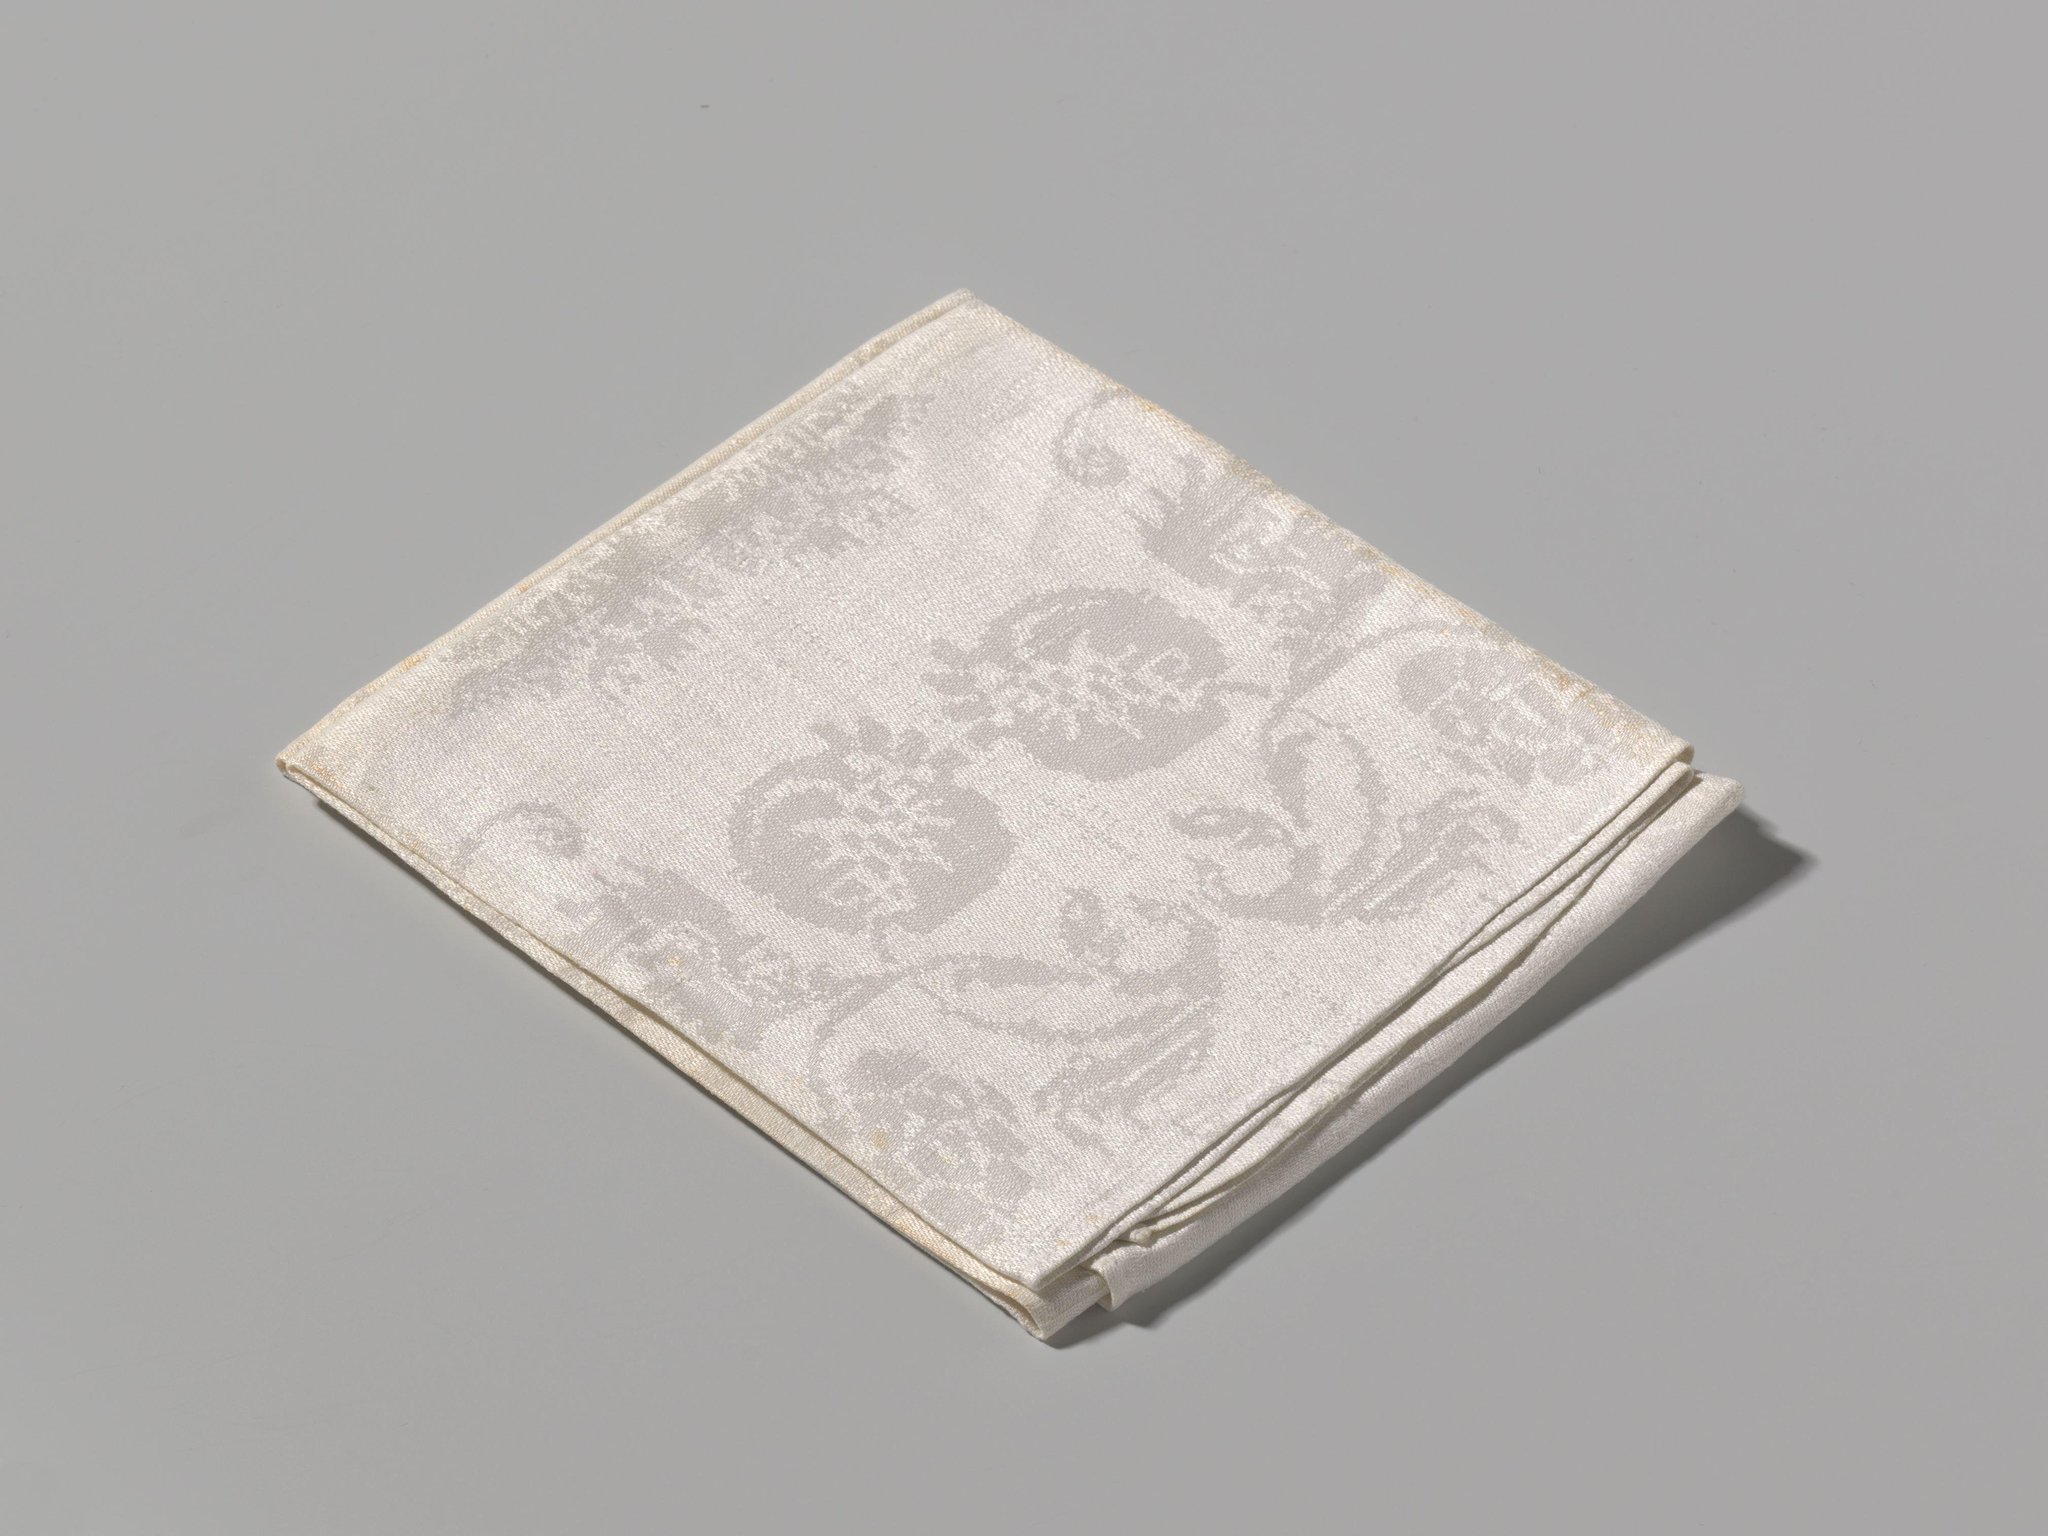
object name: woven material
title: Fragment van een tafellaken van wit linnendamast met een patroon van gestrooide bloemen en vruchten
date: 1670-1680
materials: linen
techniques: damask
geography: flanders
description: Fragment van een tafellaken van wit linnendamast met een patroon van gestrooide bloemen en vruchten.